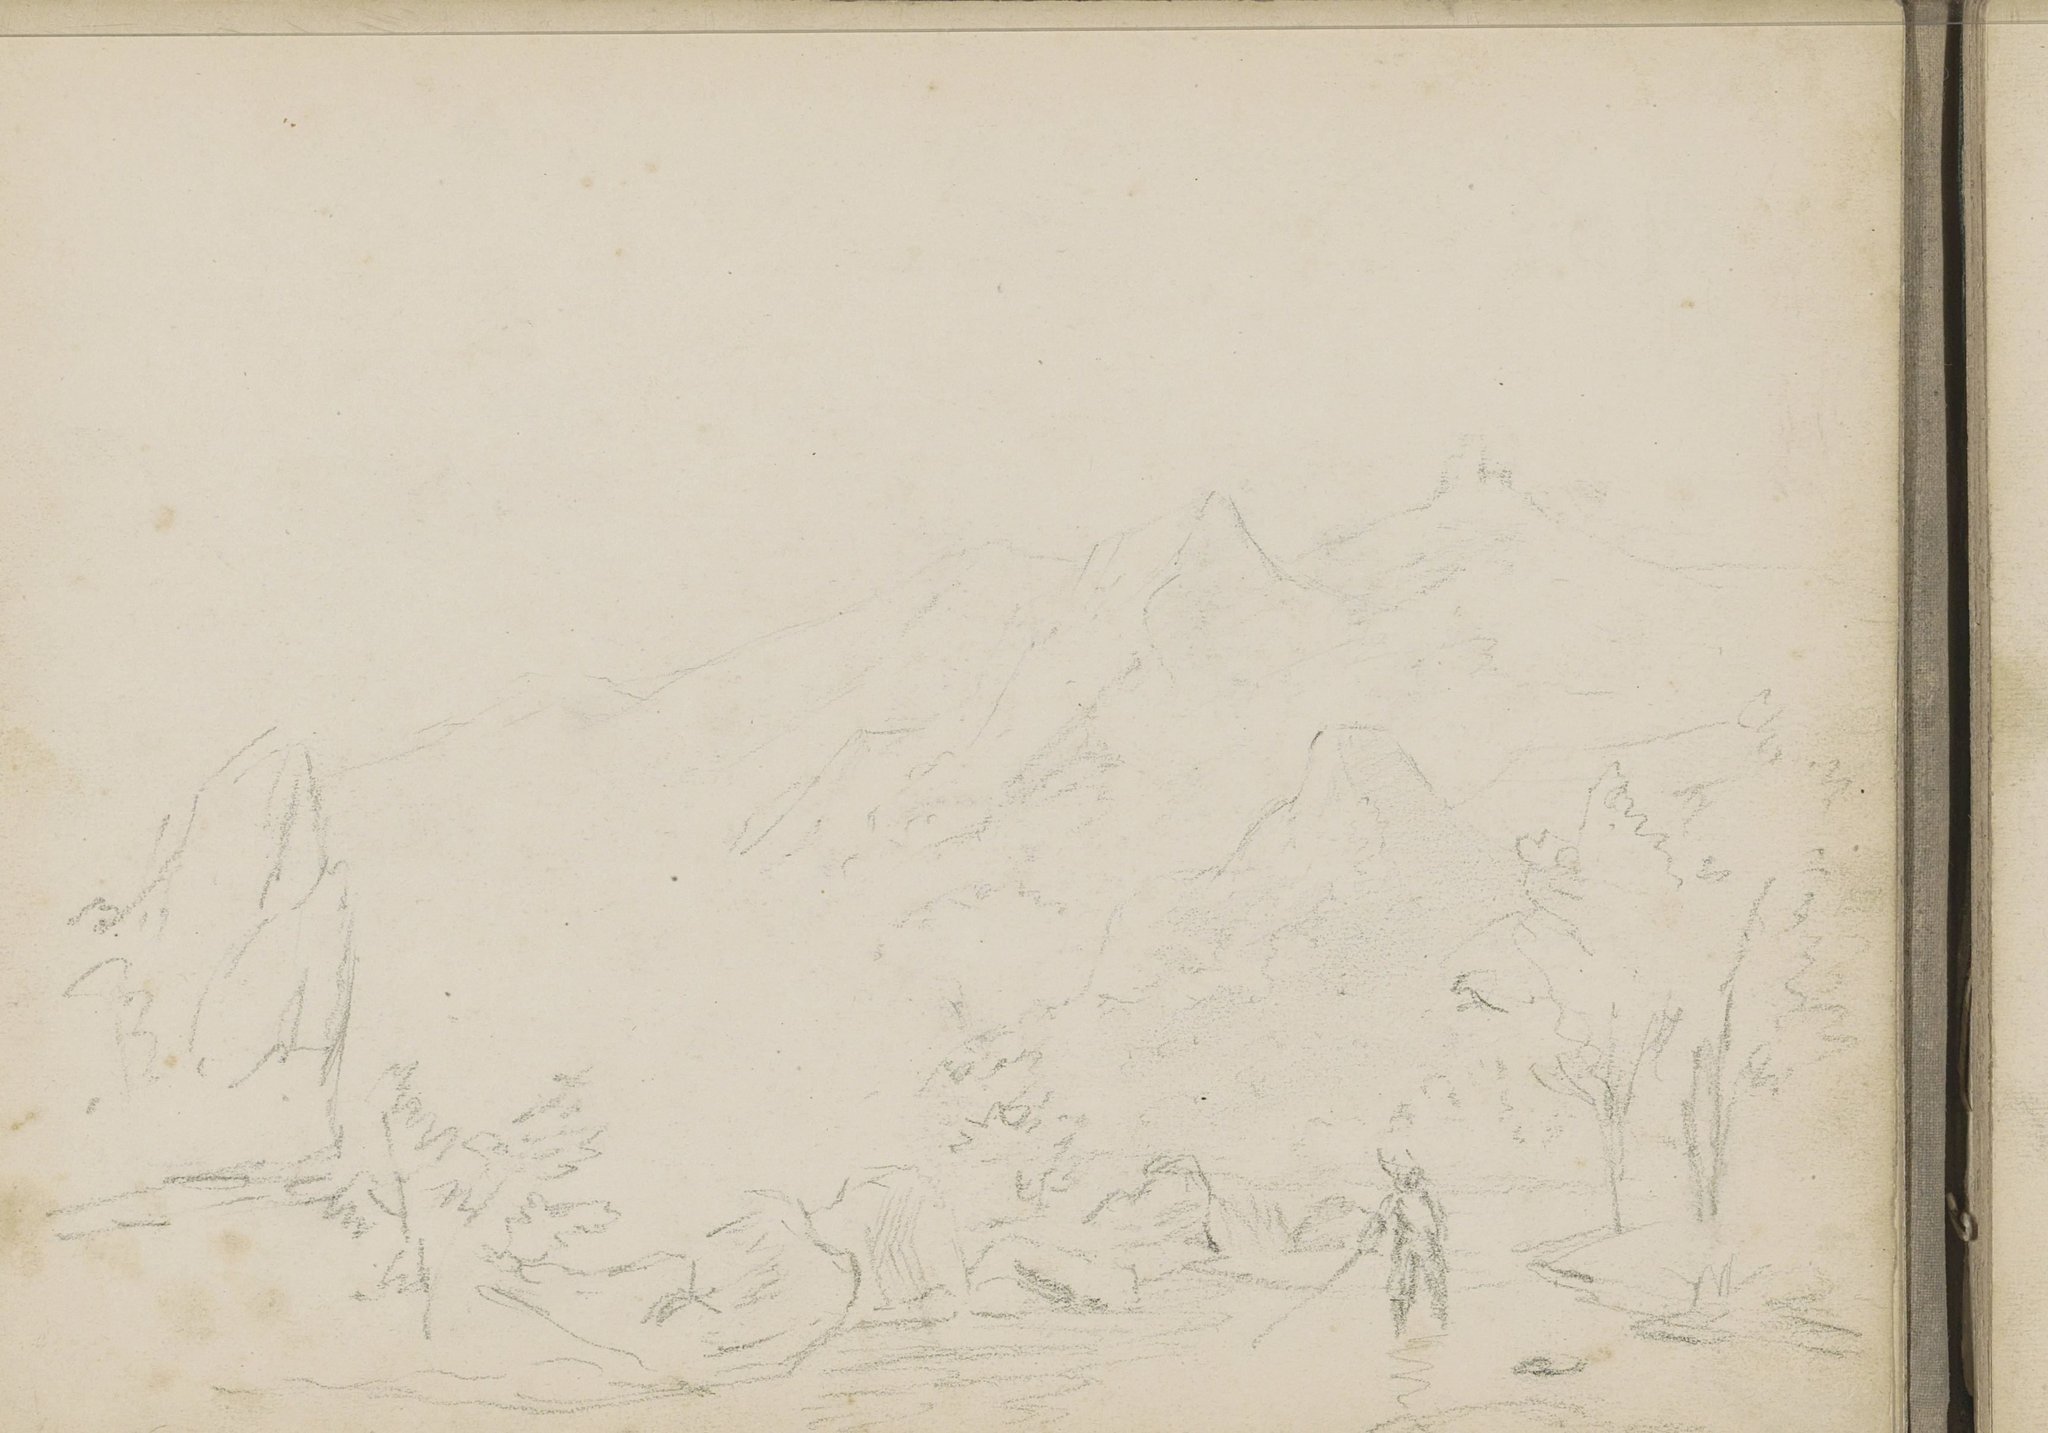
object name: sketchbook leaf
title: Berglandschap met wandelaar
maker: willem cornelis rip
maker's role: draughtsman, painter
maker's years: 1856-1922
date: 1874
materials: paper, pencil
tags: mountains (+ landscape with figures, staffage), 'en route', traveller under way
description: Blad 8 verso uit een schetsboek met 27 losse bladen.